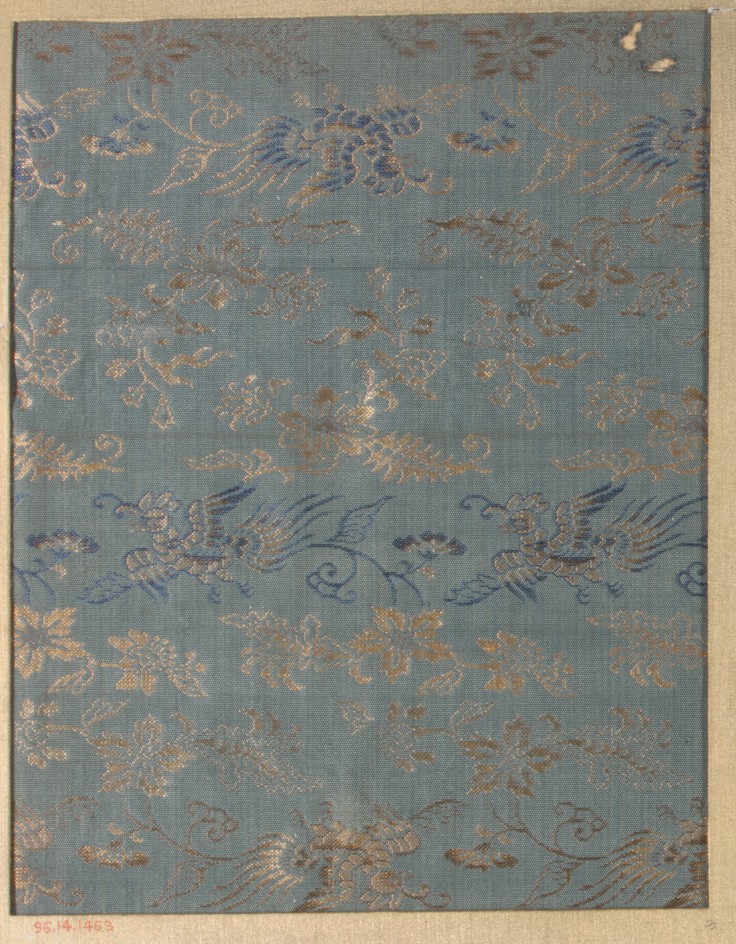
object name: piece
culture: japanese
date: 1701-1900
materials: silk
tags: birds